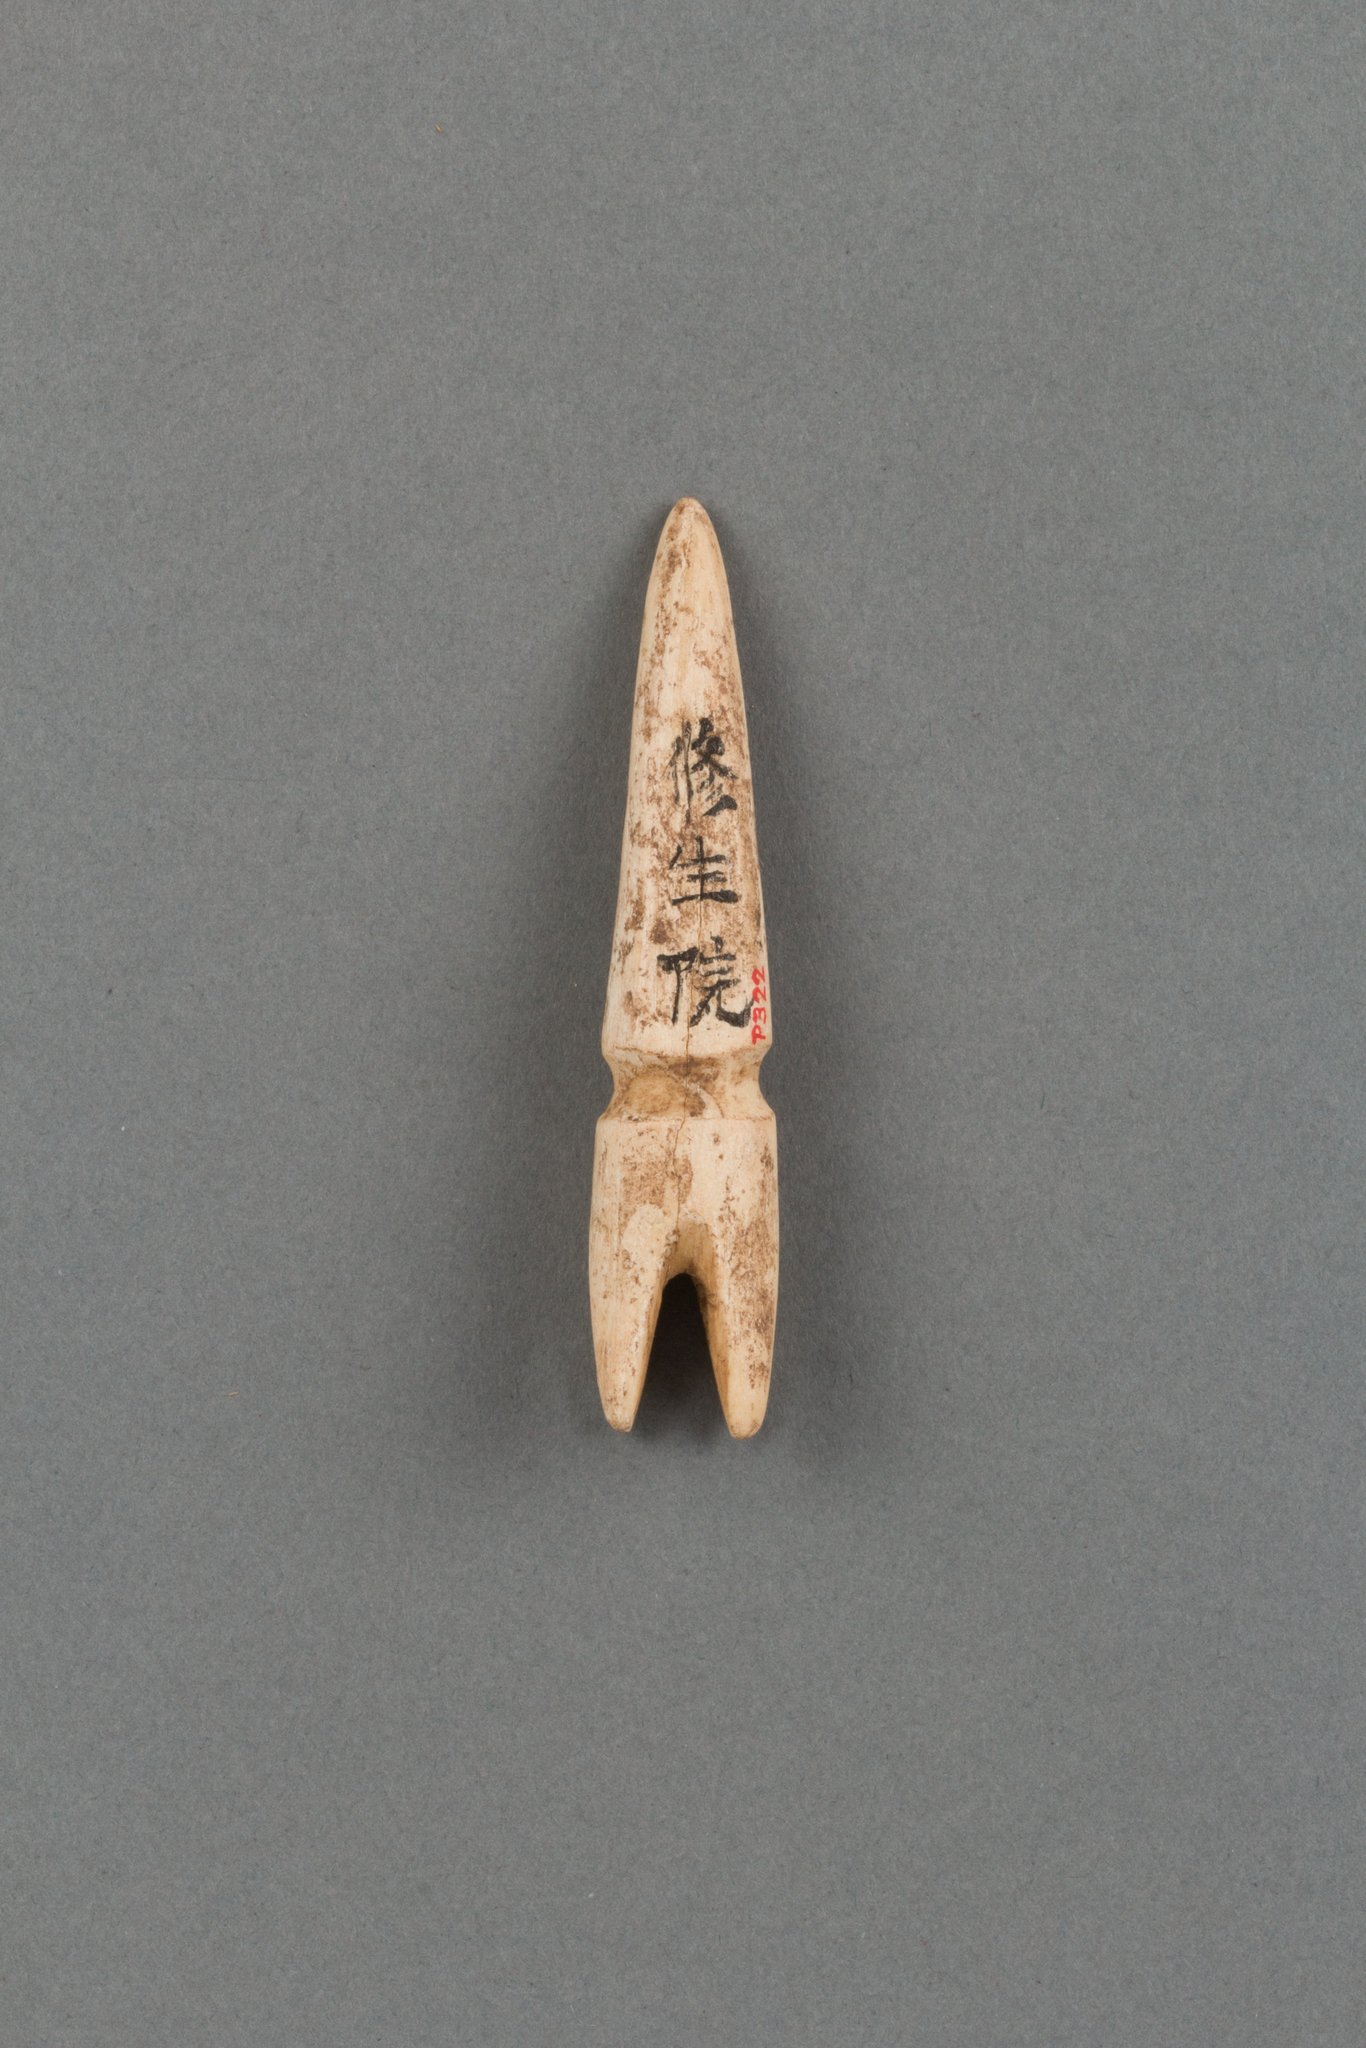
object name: body ornament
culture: japanese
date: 1200-200 BCE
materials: bone